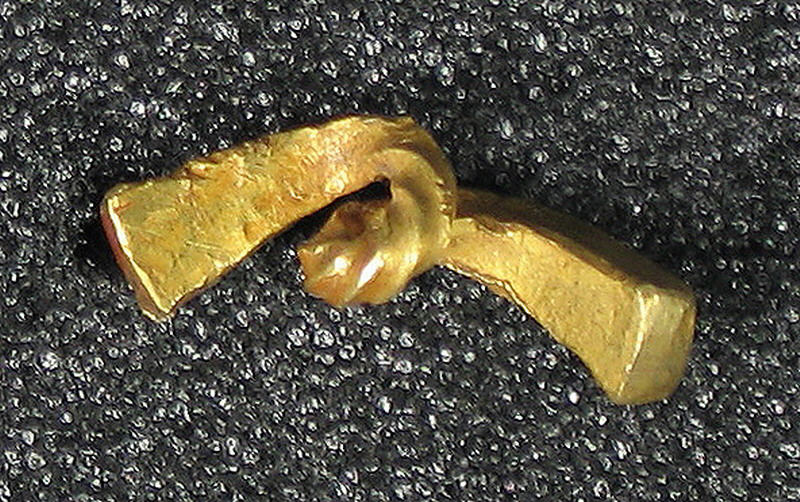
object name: ornament fragment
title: Fragment of an Ornament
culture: indonesian, central java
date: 701-1200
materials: gold